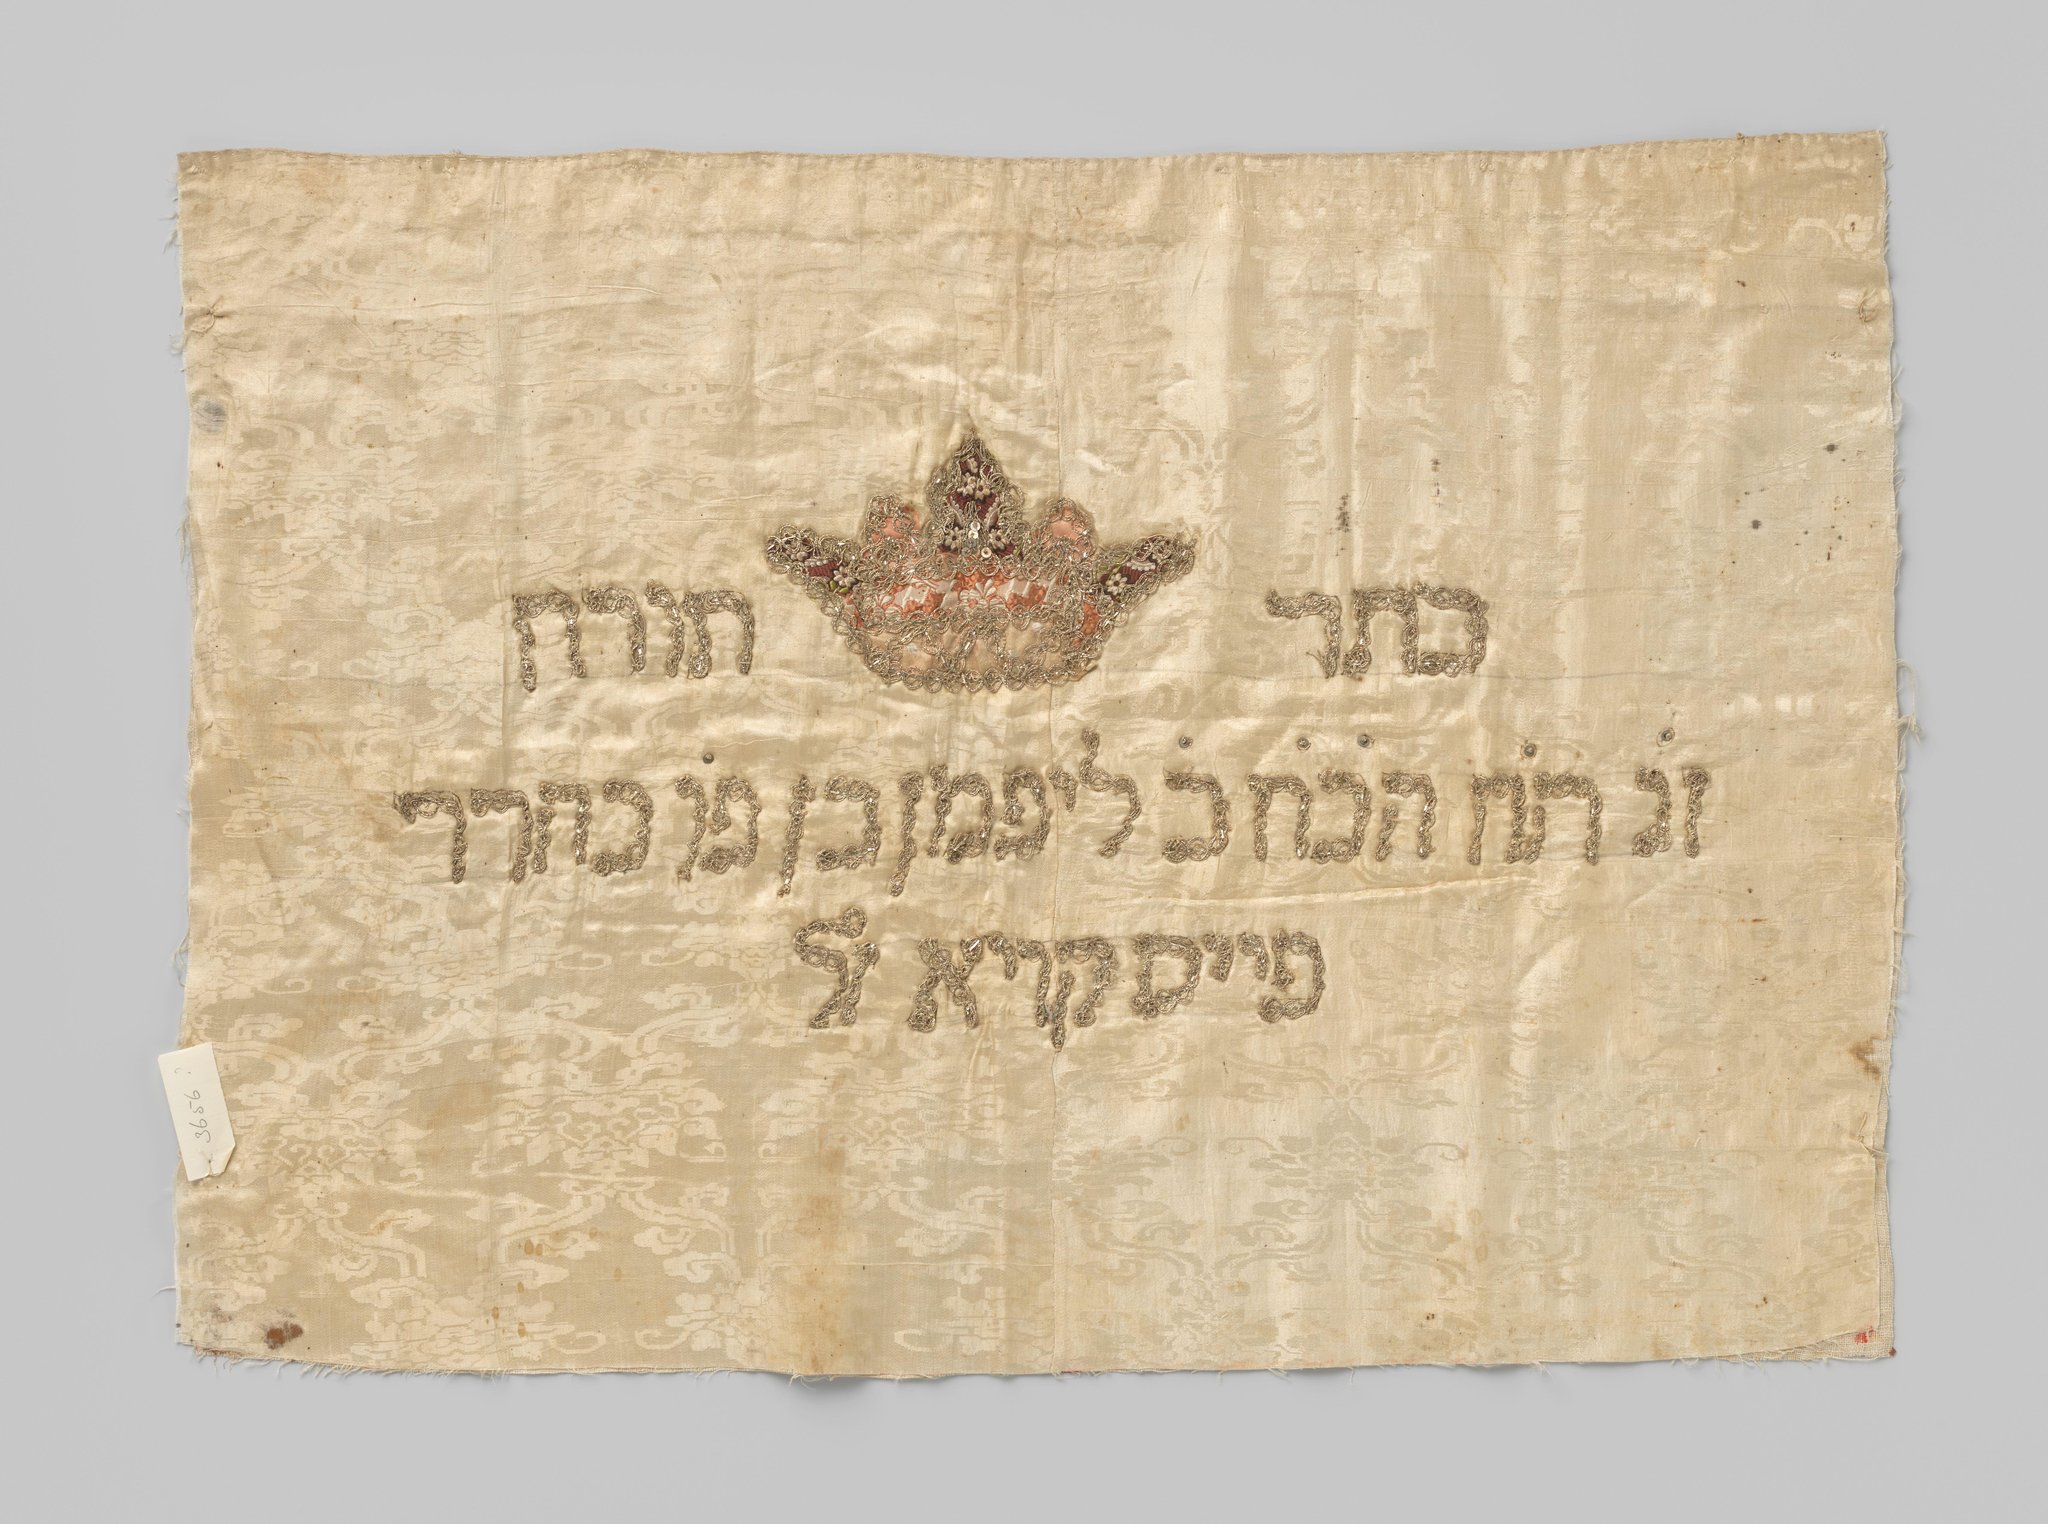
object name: fragment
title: Geborduurd satijndamasten fragment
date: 1700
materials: linen, textile, thread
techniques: embroidered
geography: japan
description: Fragment van wit satijndamast, waarop een met zilverdraad geborduurde kroon en letters. Het fragment bestaat uit twee aaneengezette patronen. Het fragment is met linnen gevoerd.